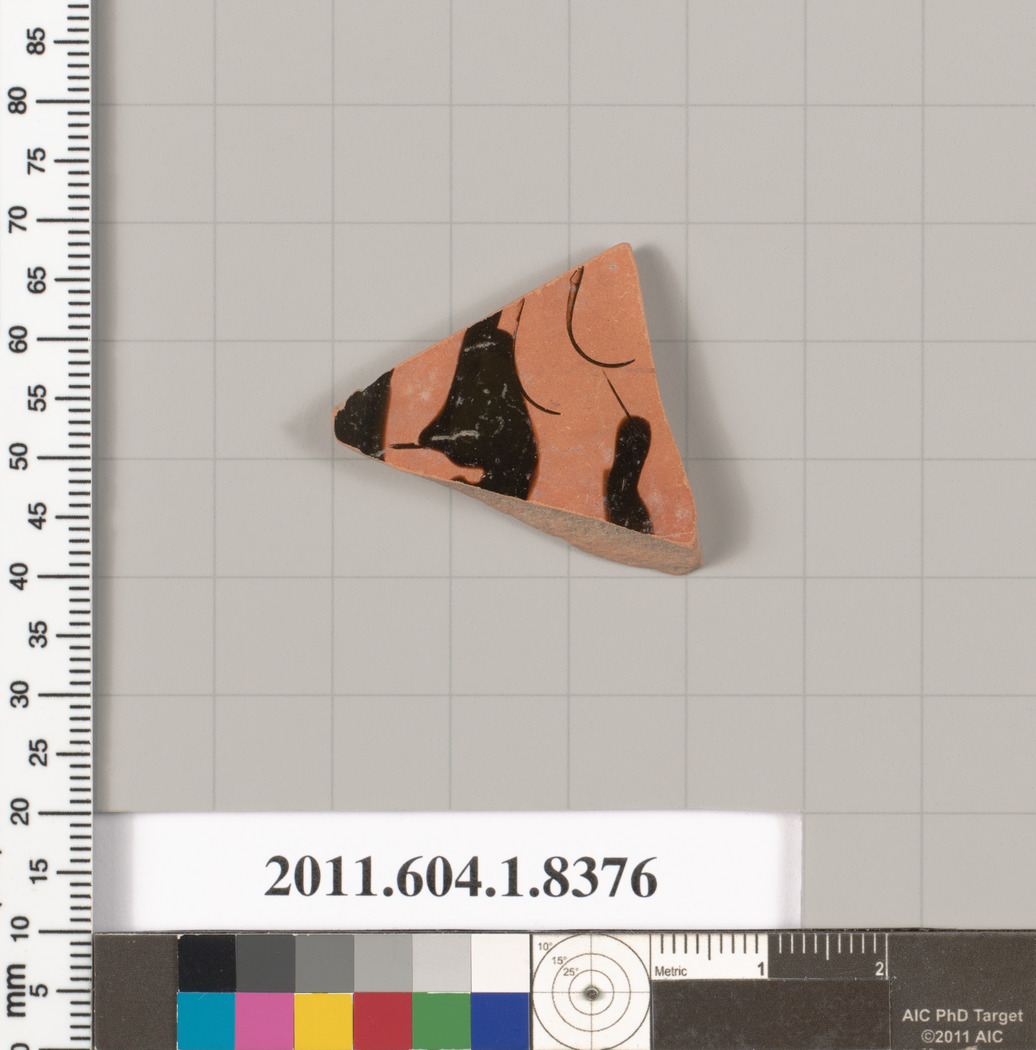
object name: kylix fragment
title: Terracotta fragment of a kylix (drinking cup)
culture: greek, attic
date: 367-335 BCE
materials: terracotta